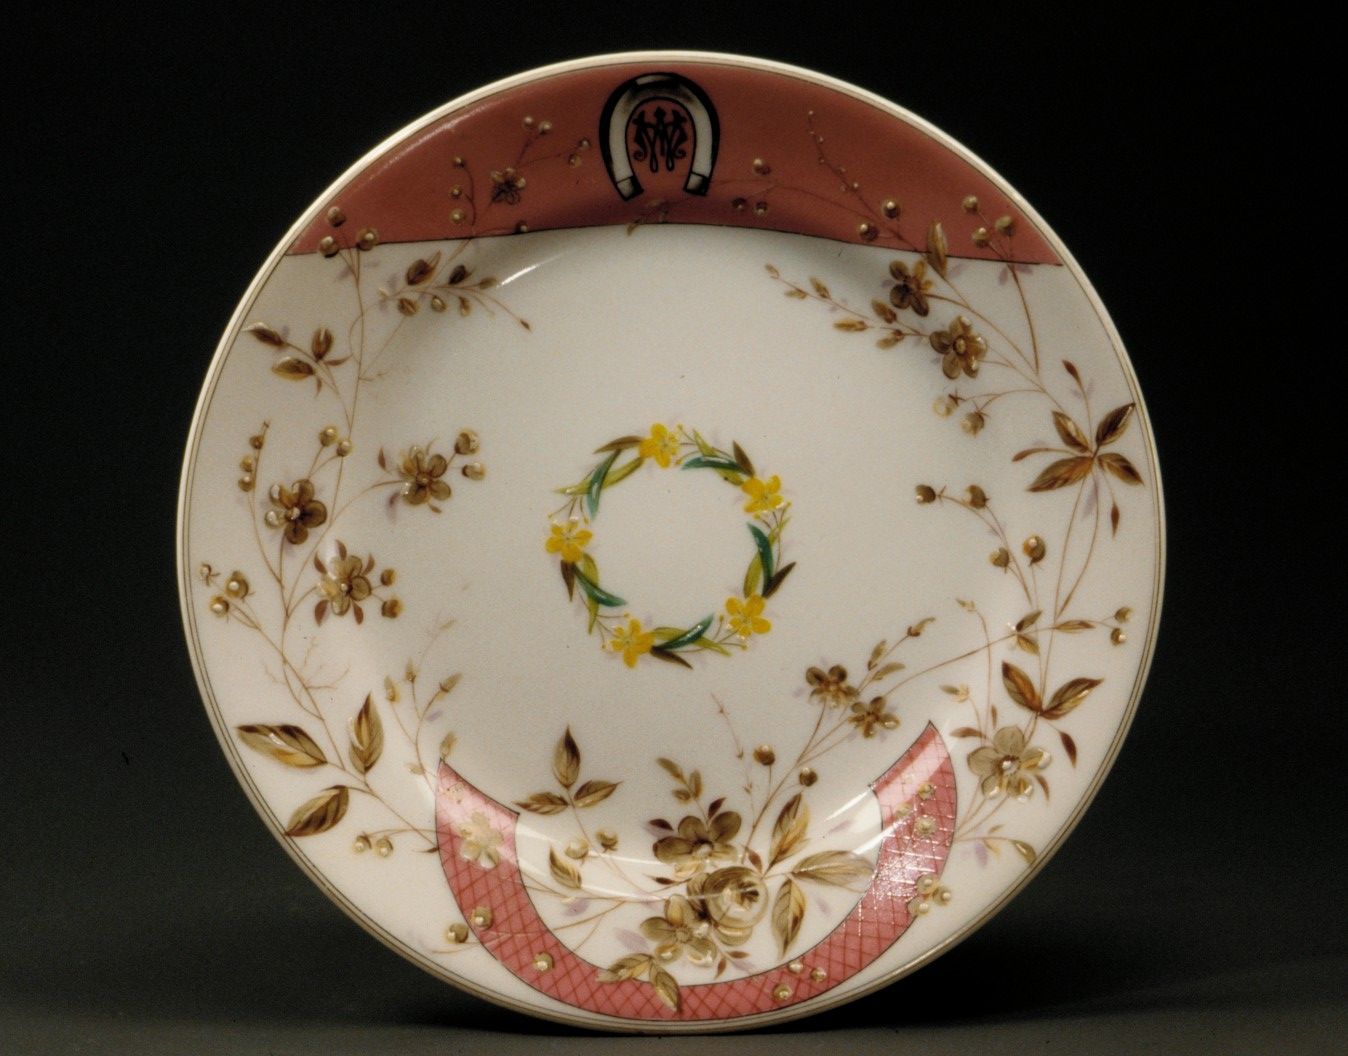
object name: plate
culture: american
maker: union porcelain works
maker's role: maker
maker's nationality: american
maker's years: 1863-1922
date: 1880-1885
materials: porcelain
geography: united states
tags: flowers